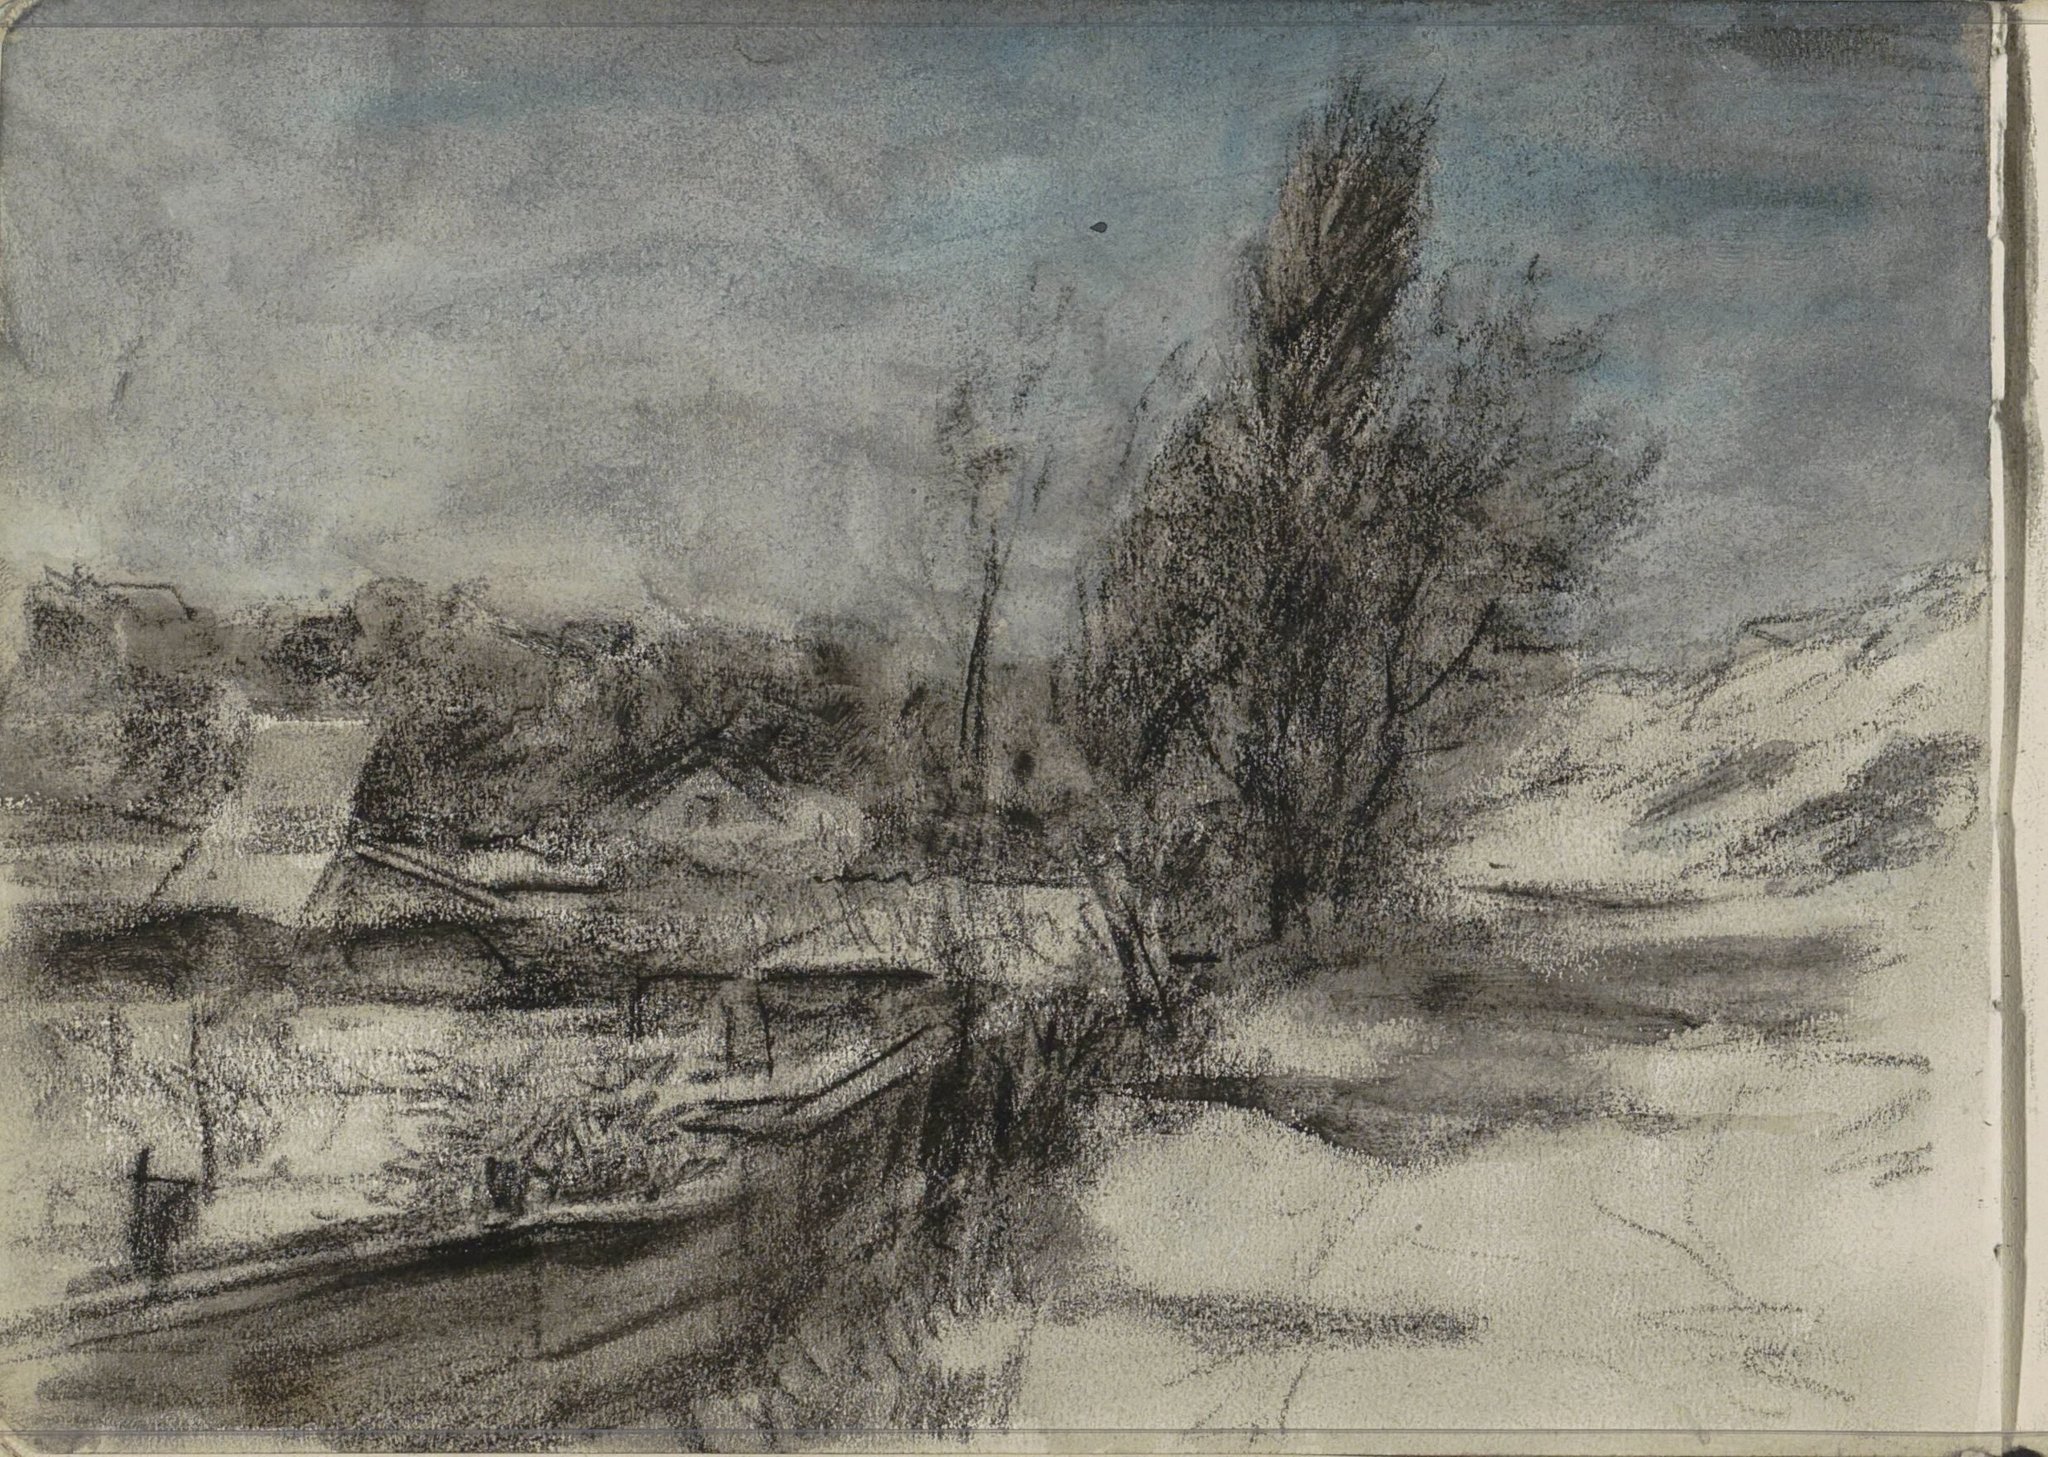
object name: sketchbook leaf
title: Duinlandschap met bebouwing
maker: johan antonie de jonge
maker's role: draughtsman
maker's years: 1864-1927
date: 1881-1927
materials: chalk, paper, watercolor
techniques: stumping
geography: south holland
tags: dunes (sea not visible); in the dunes, civic architecture; edifices; dwellings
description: Duinlandschap met bebouwing. Blad 24 verso uit een schetsboek met 28 bladen.